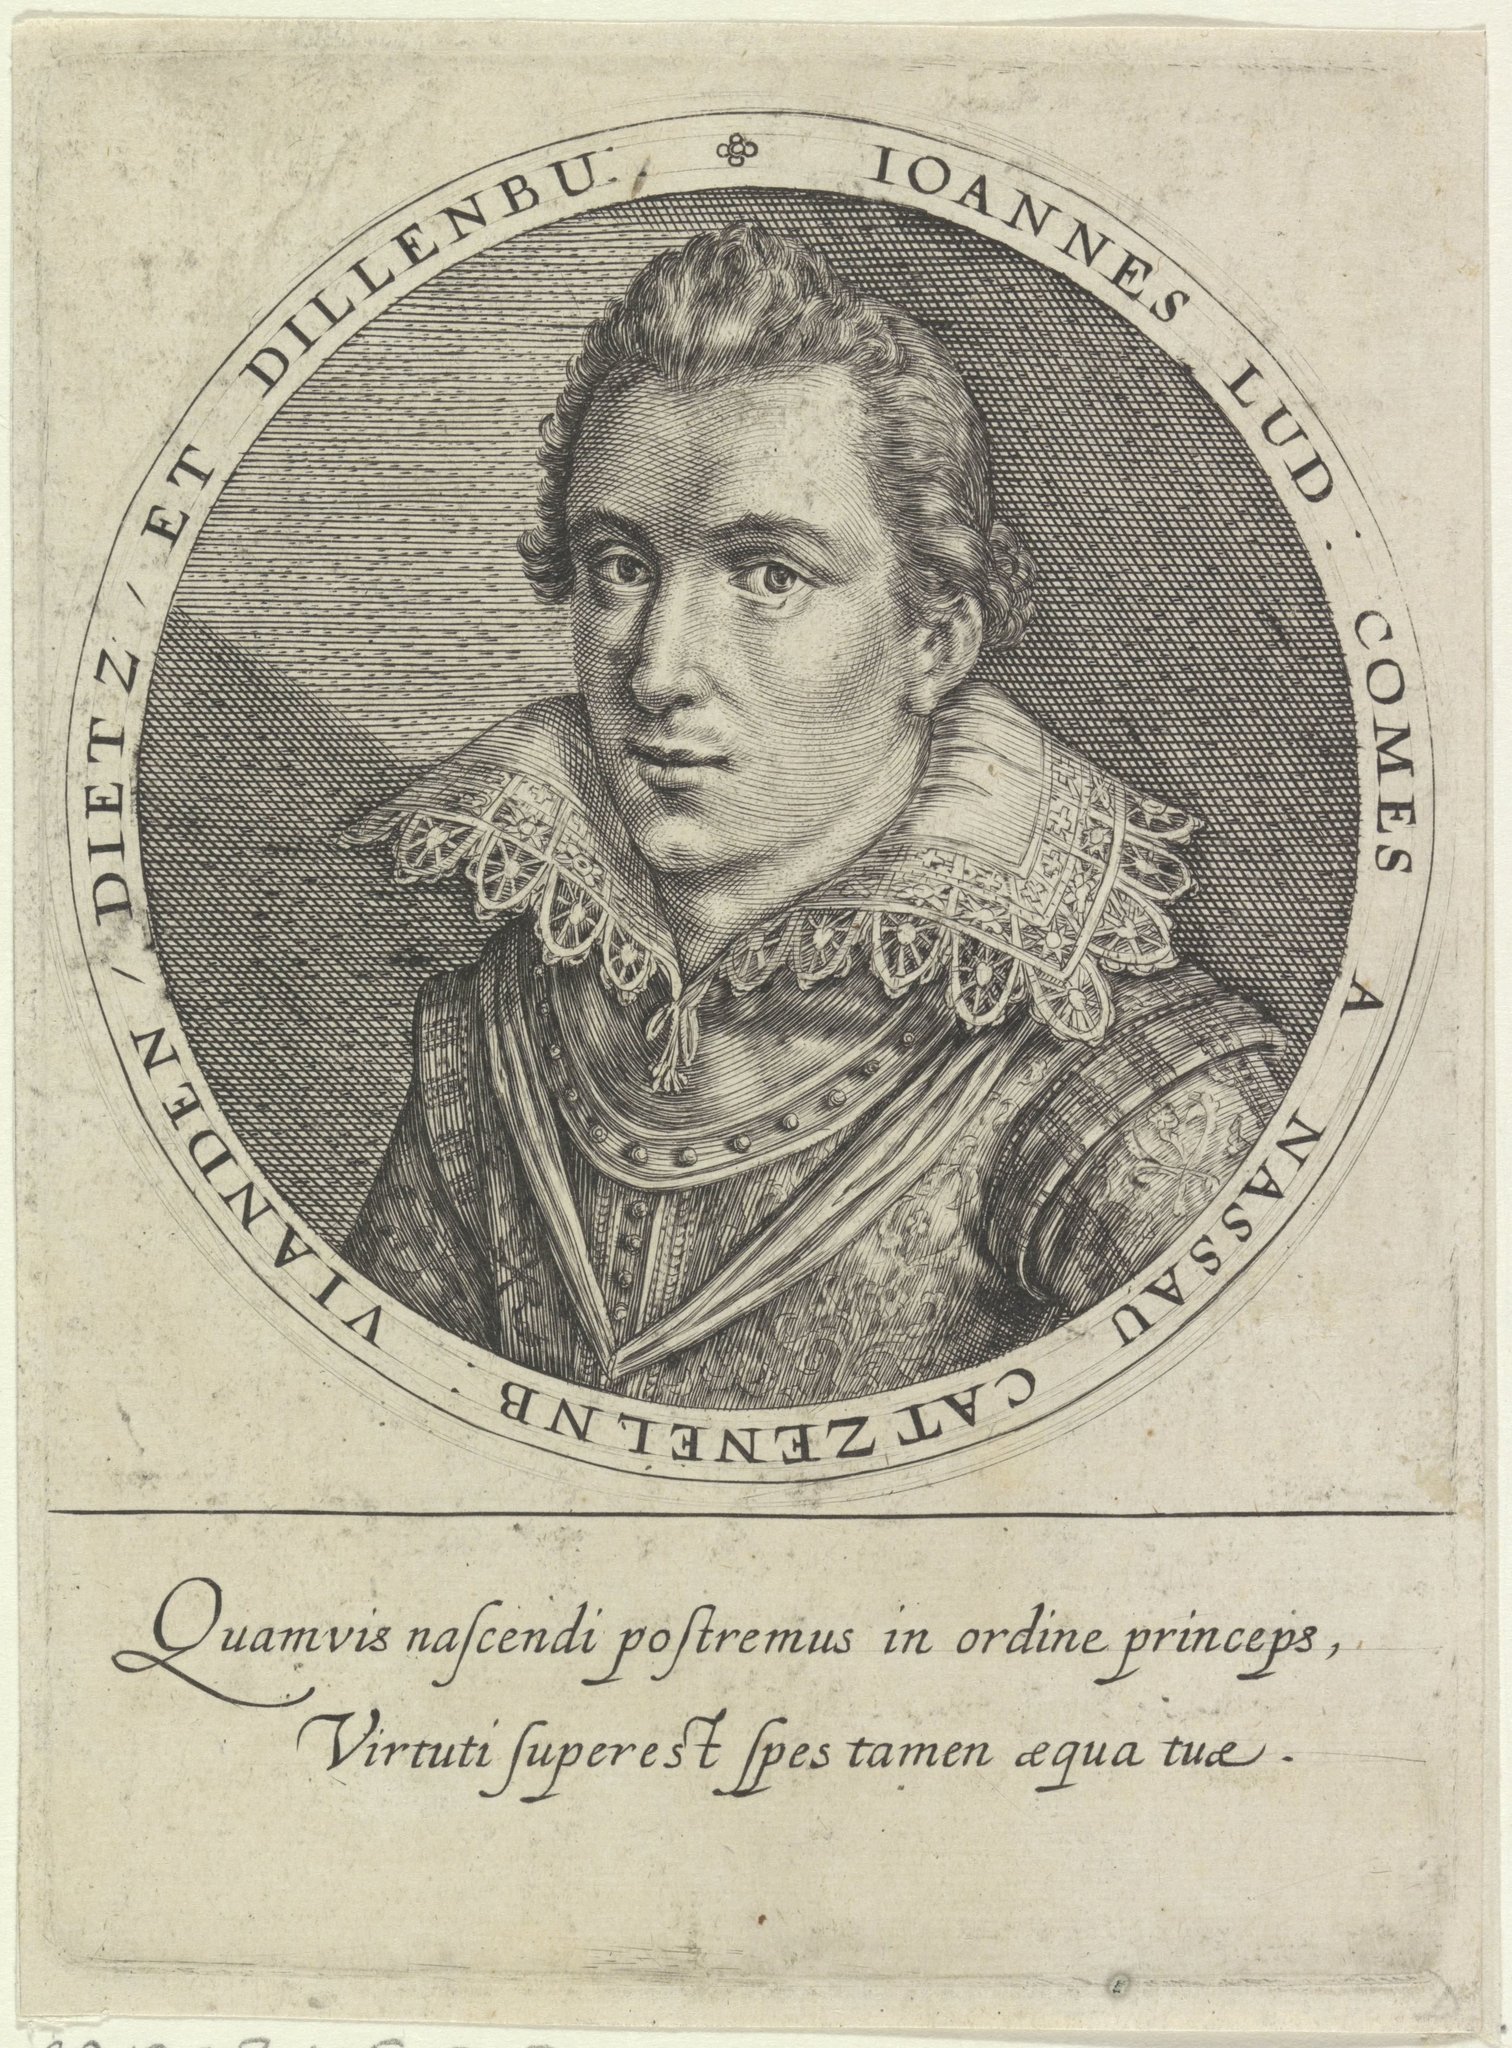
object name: print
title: Portret van Johan Lodewijk, graaf van Nassau-Hadamar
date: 1615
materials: paper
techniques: engraving, etching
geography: utrecht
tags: dillenburg, johan lodewijk graaf van nassau-hadamar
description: De hier vermelde titel verwijst naar de hoogst verkregen titel van de geportretteerde, niet per se naar de titel die de geportretteerde op deze voorstelling draagt. Prent uit: Buchelius, Arnoldus. Nassovischen Oraignen-boom, daer by ghevoecht, de conterfeytsels der voornaemster helden. = Malus Aurantius Nassovicus. Utrecht: Salomon de Roy, 1615.